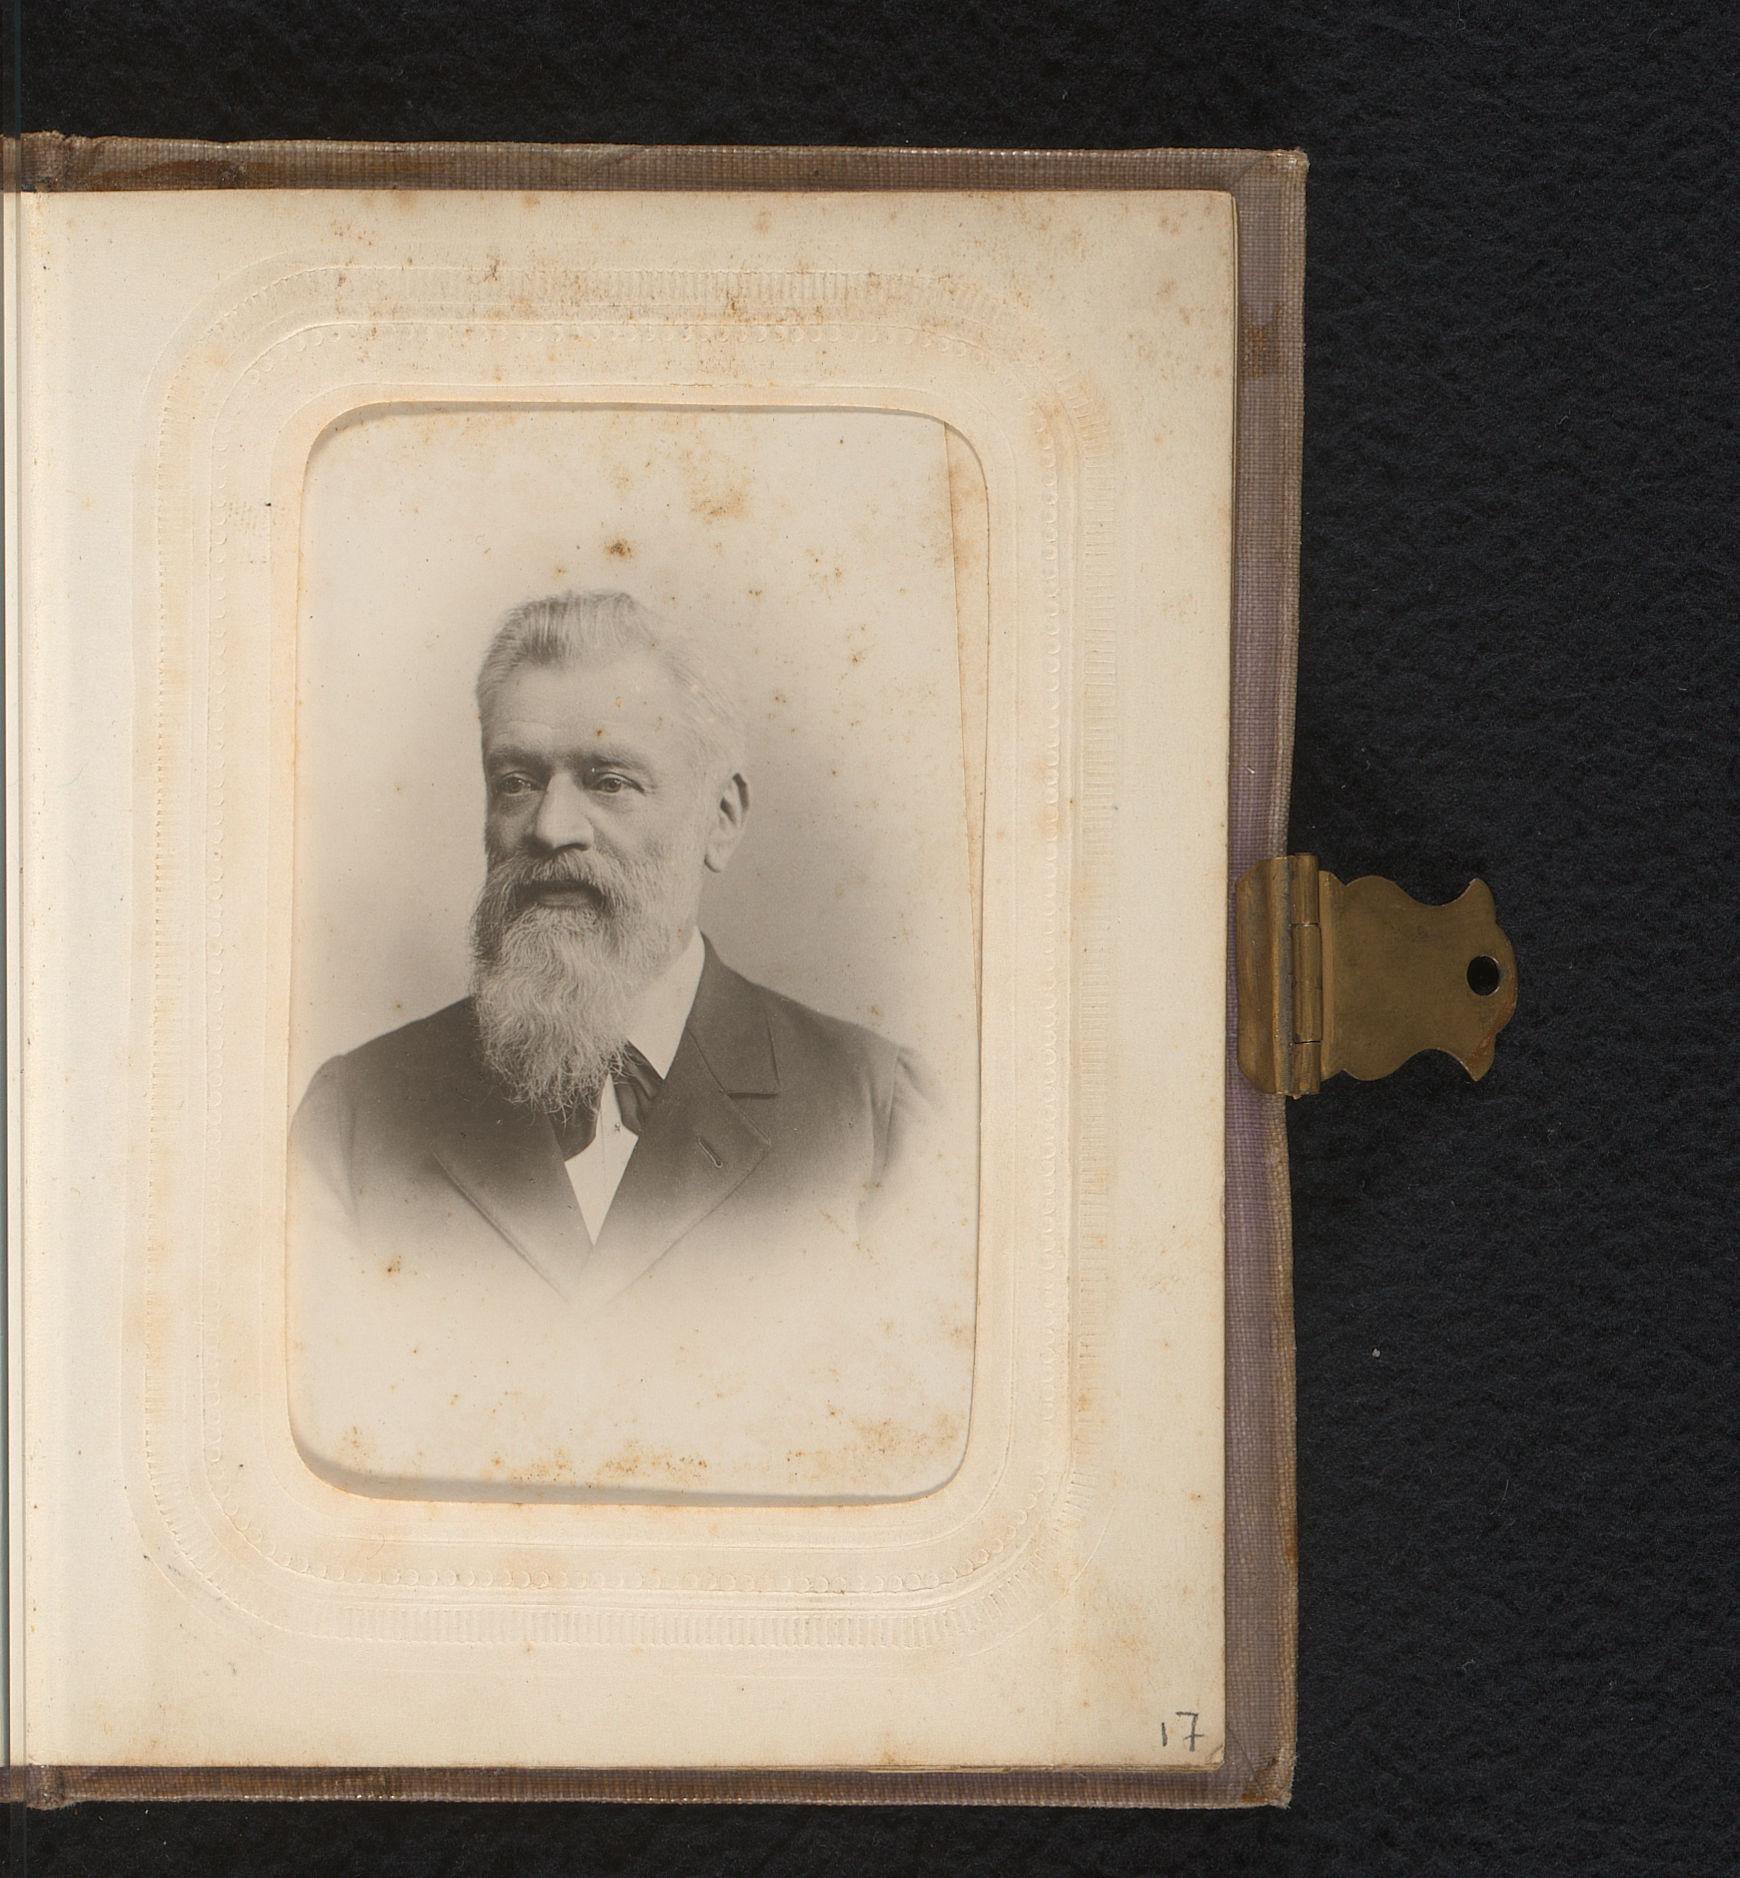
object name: carte de visite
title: Portret van een man met baard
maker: gustaaf adolf mögle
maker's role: fotograaf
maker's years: 1863-1914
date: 1896-1914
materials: cardboard, photographic support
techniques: matte daylight collodion silver print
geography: the hague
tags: historical persons, beard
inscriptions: inscription: ‘Photographisch/ Atelier/ G. A. Mögle/ La Haye/ 10. Bazarstraat/ Vergrootingen naar elk portret./ De plaat blijft voor nabestelling/ bewaard.’